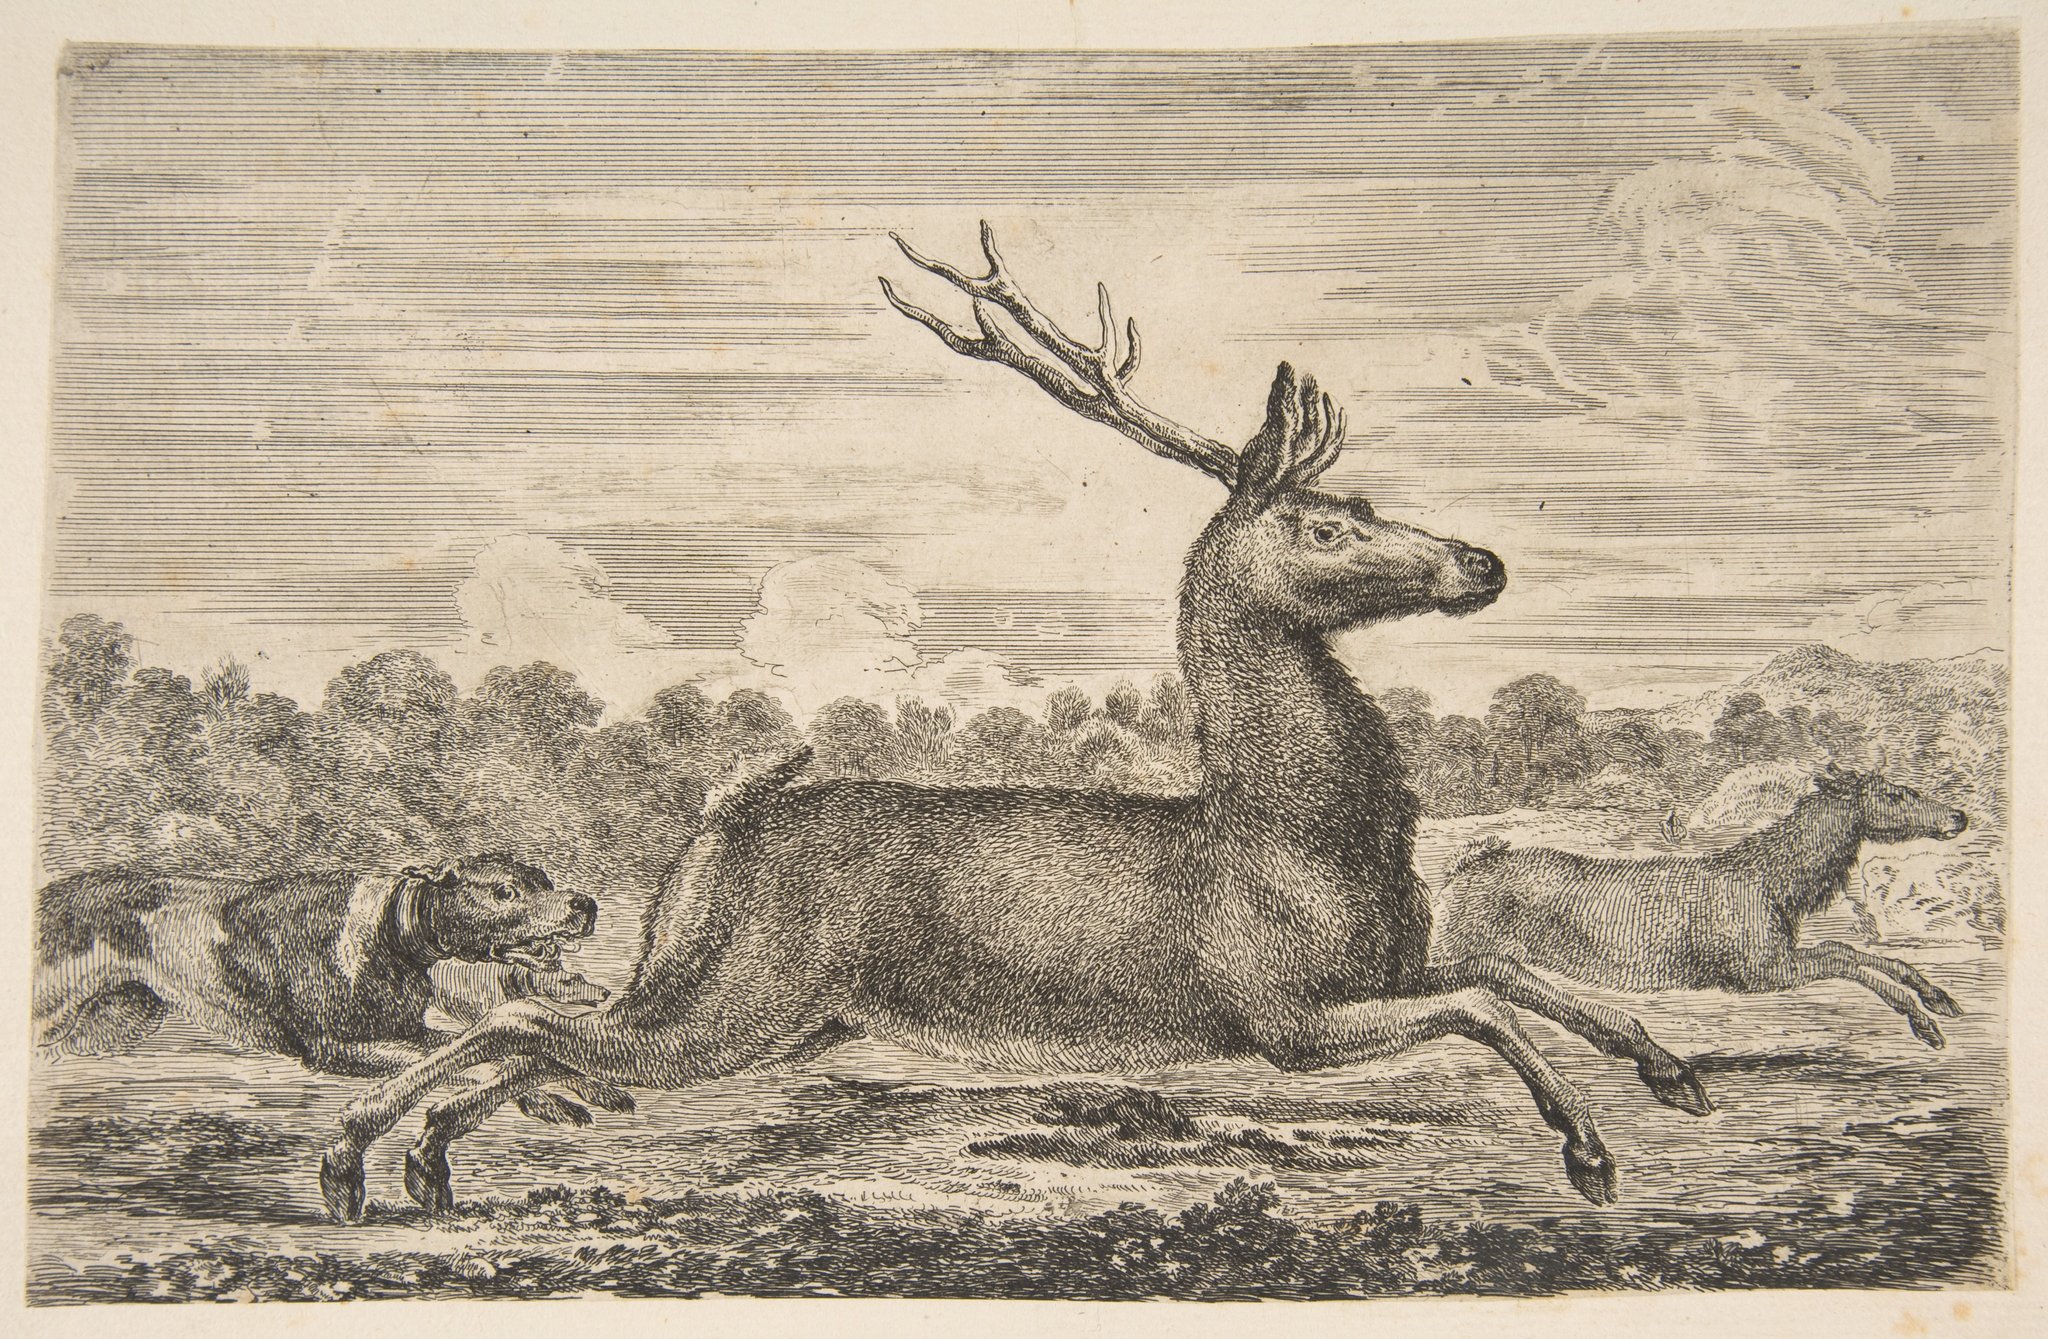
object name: print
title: Hounds Chasing a Stag and a Doe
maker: stefano della bella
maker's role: artist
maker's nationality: italian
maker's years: 1610-1664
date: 1654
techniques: etching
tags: hunting,deer,dogs